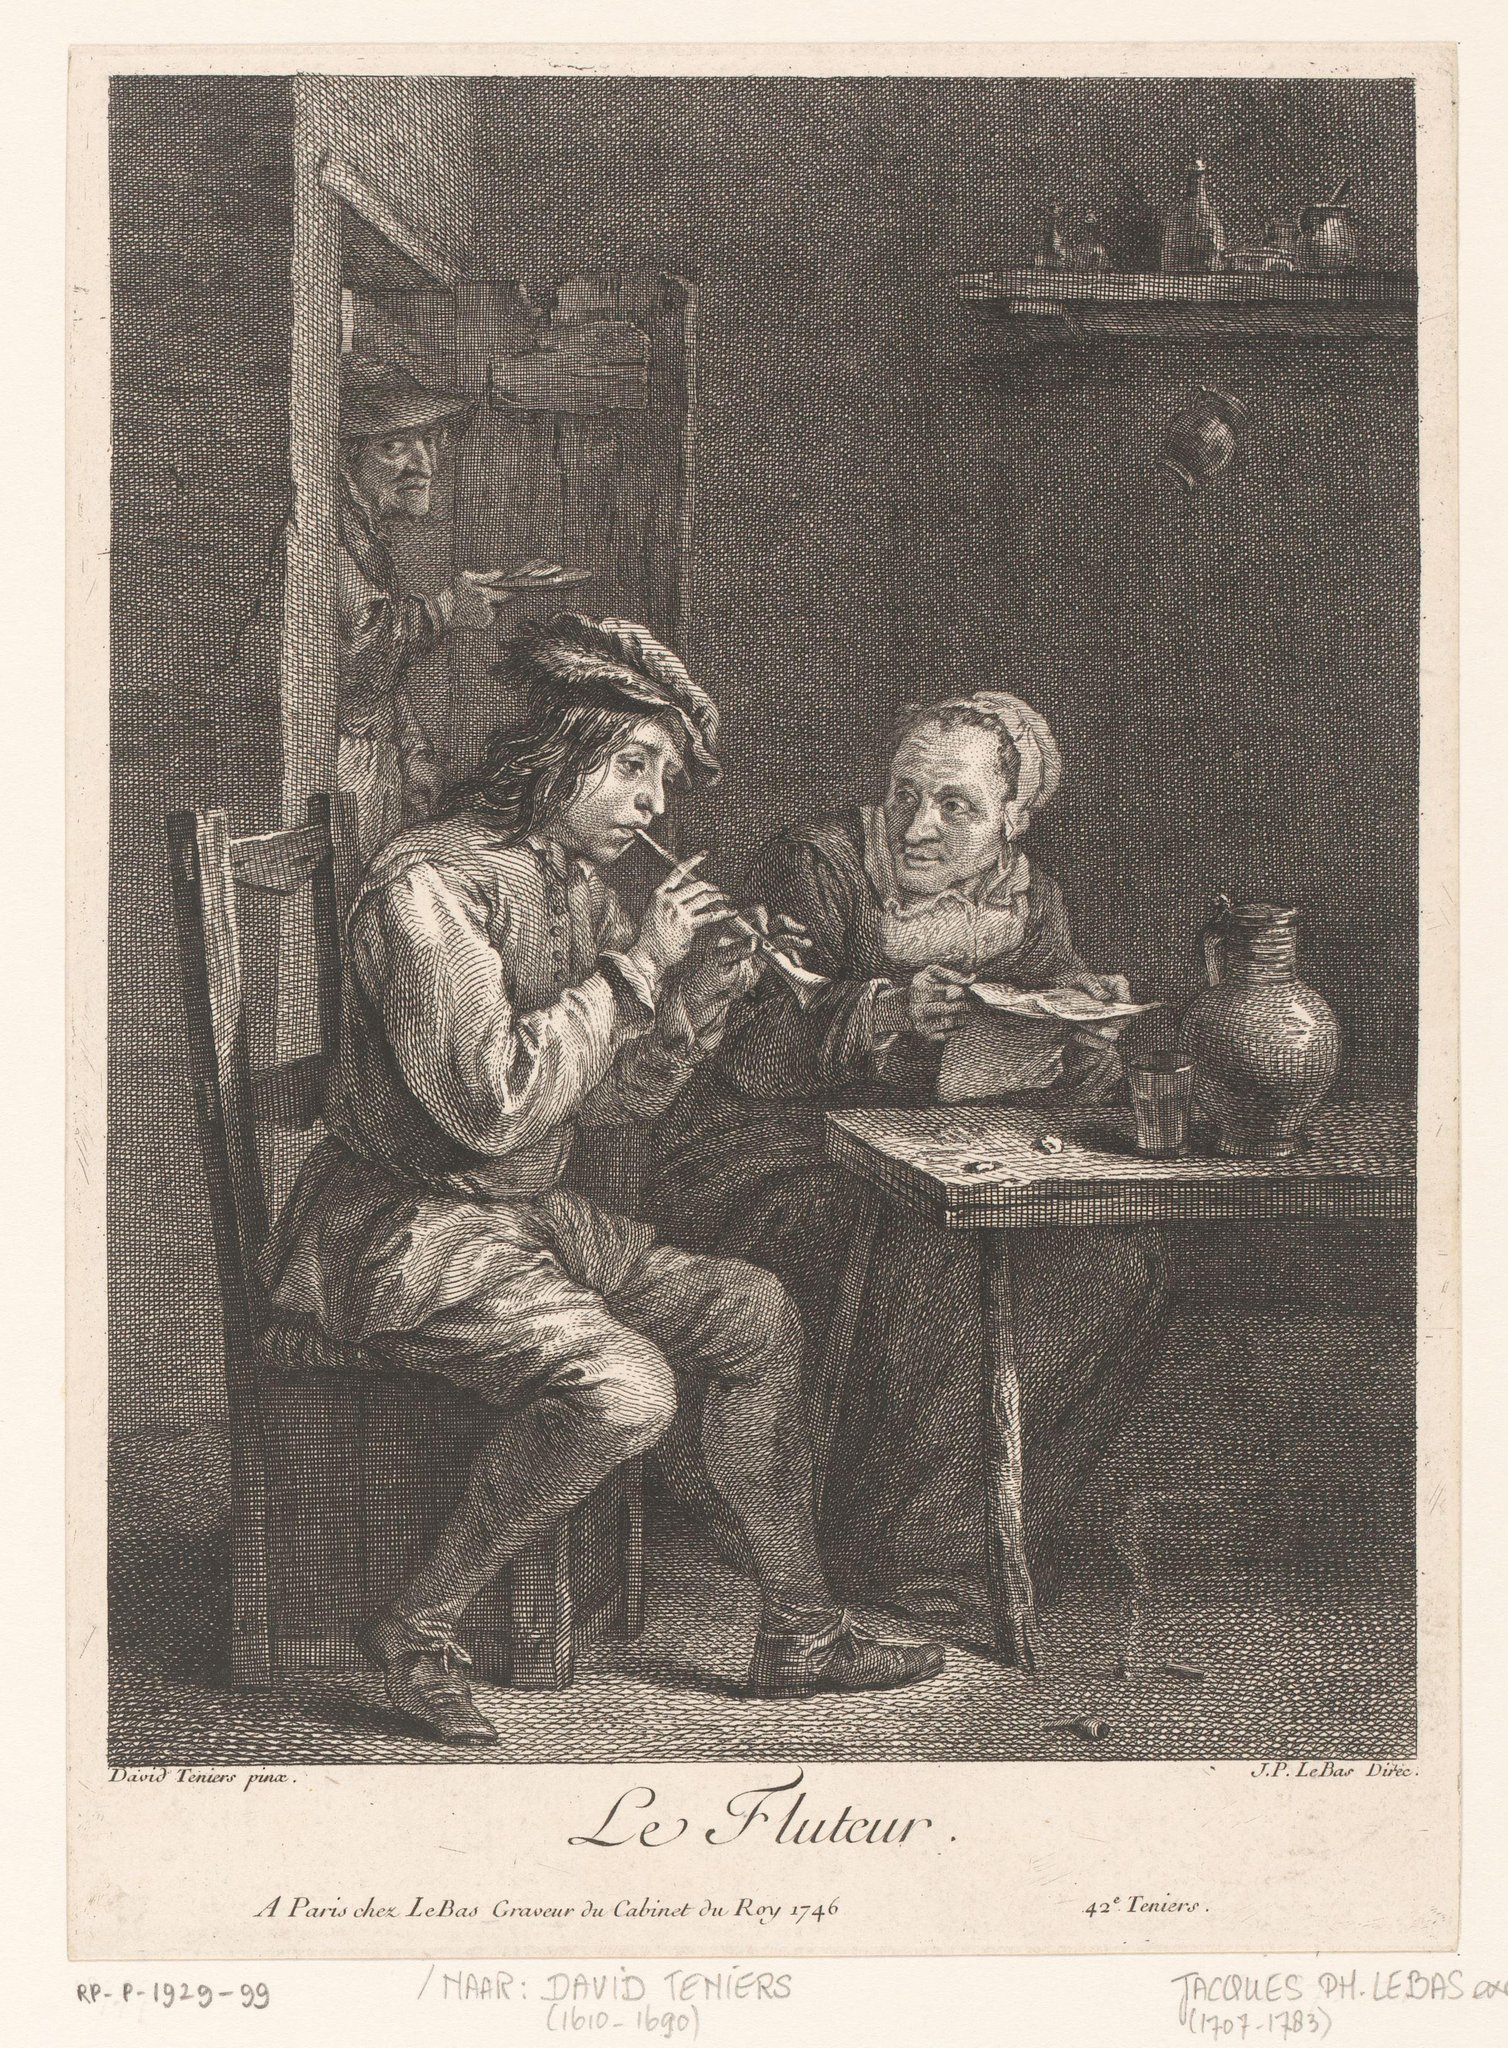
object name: print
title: Interieur met een fluitspeler en een oude vrouw aan een tafel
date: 1746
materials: paper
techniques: engraving, etching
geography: paris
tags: making music; musician with instrument, one person playing wind instrument, flute, aulos, tibia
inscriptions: collector's mark: Lugt 240